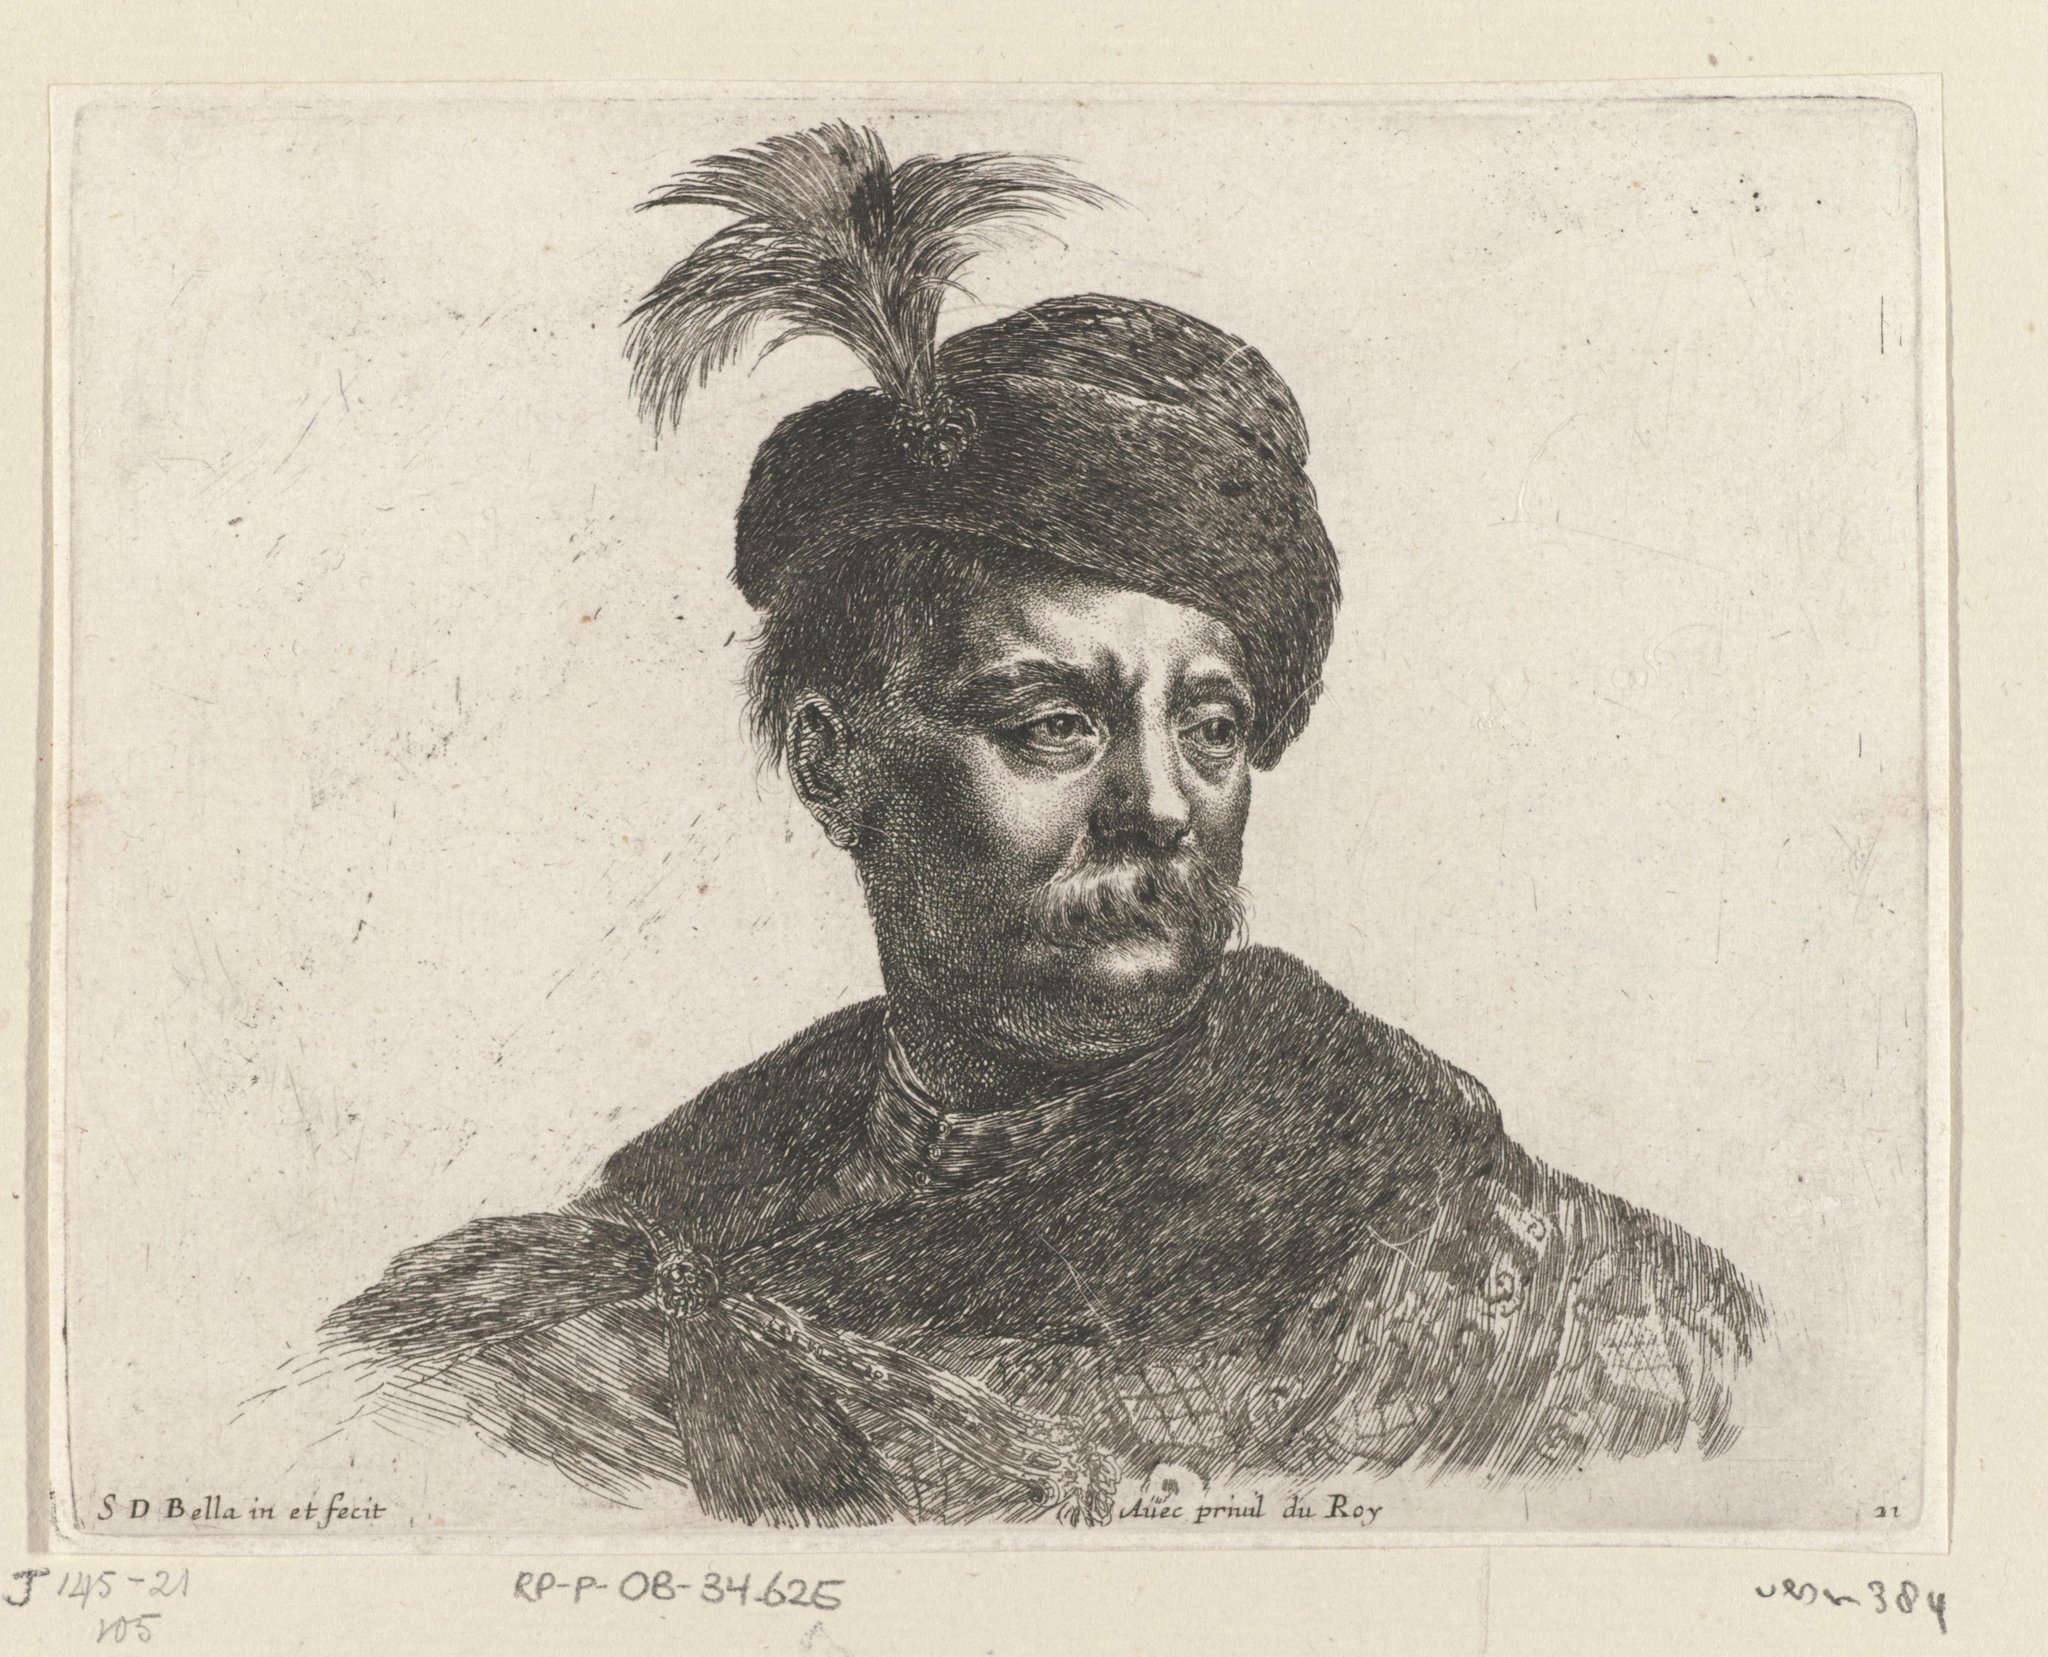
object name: print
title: De beginselen van het tekenen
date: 1620-1664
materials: paper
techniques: etching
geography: paris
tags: europeans, moustache, old man, head-gear: hat (+ feathers used for clothes)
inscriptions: collector's mark: Lugt 240